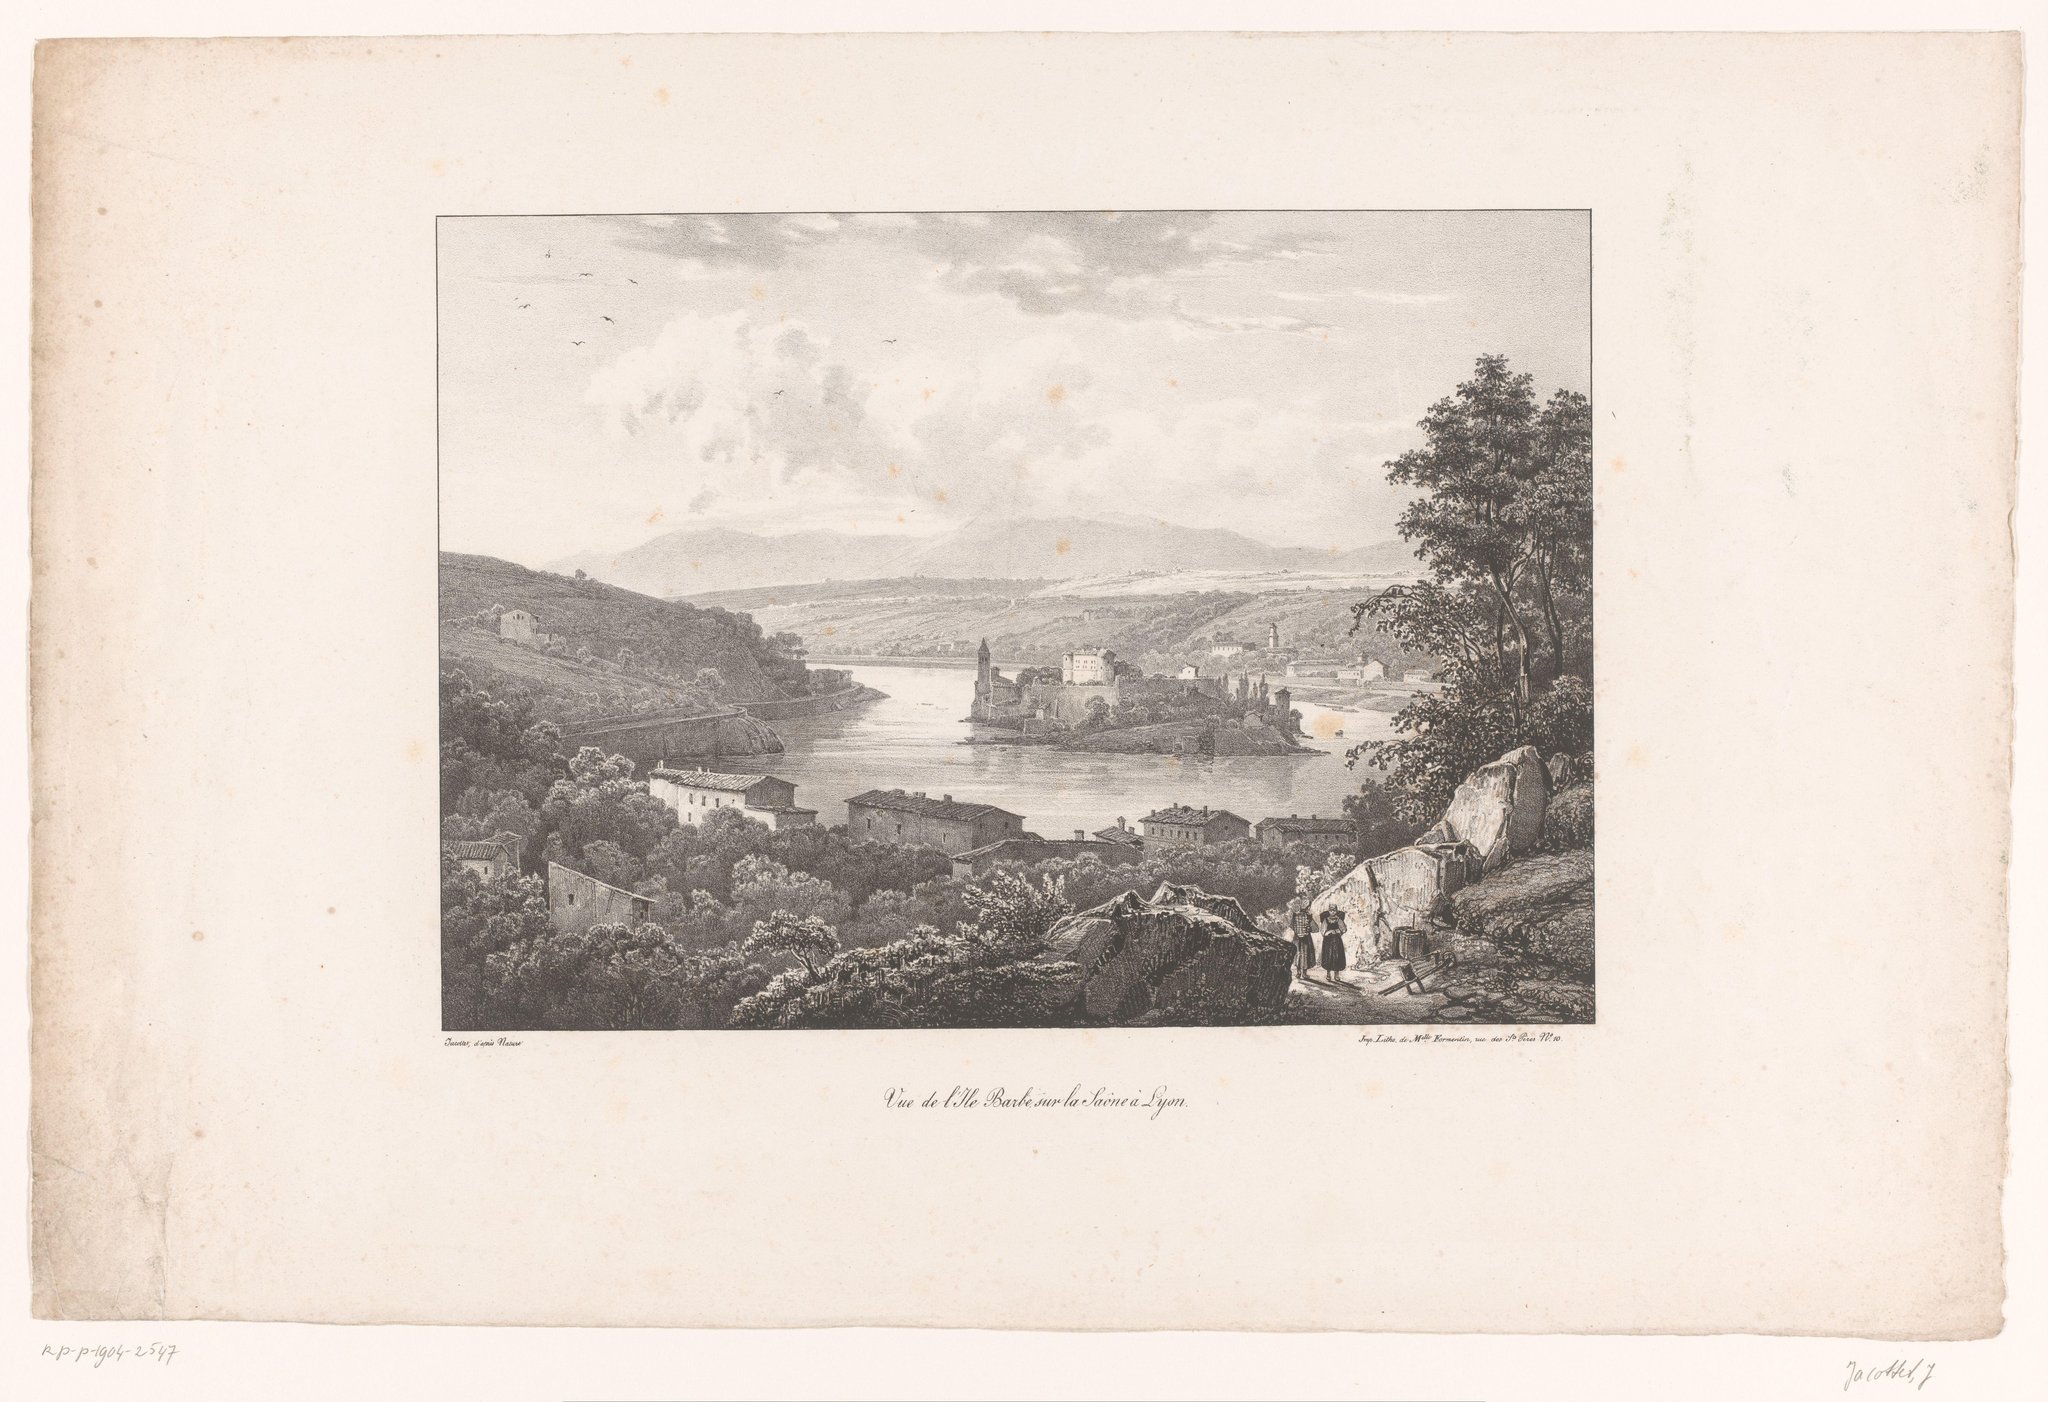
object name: print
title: Vue de l'Ile Barbe sur la Saône à Lyon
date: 1824-1856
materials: paper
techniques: lithograph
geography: paris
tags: island (+ landscape with figures, staffage), river (+ landscape with figures, staffage), lyon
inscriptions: check stamp: ‘D U [...]’, collector's mark: Lugt 2228a